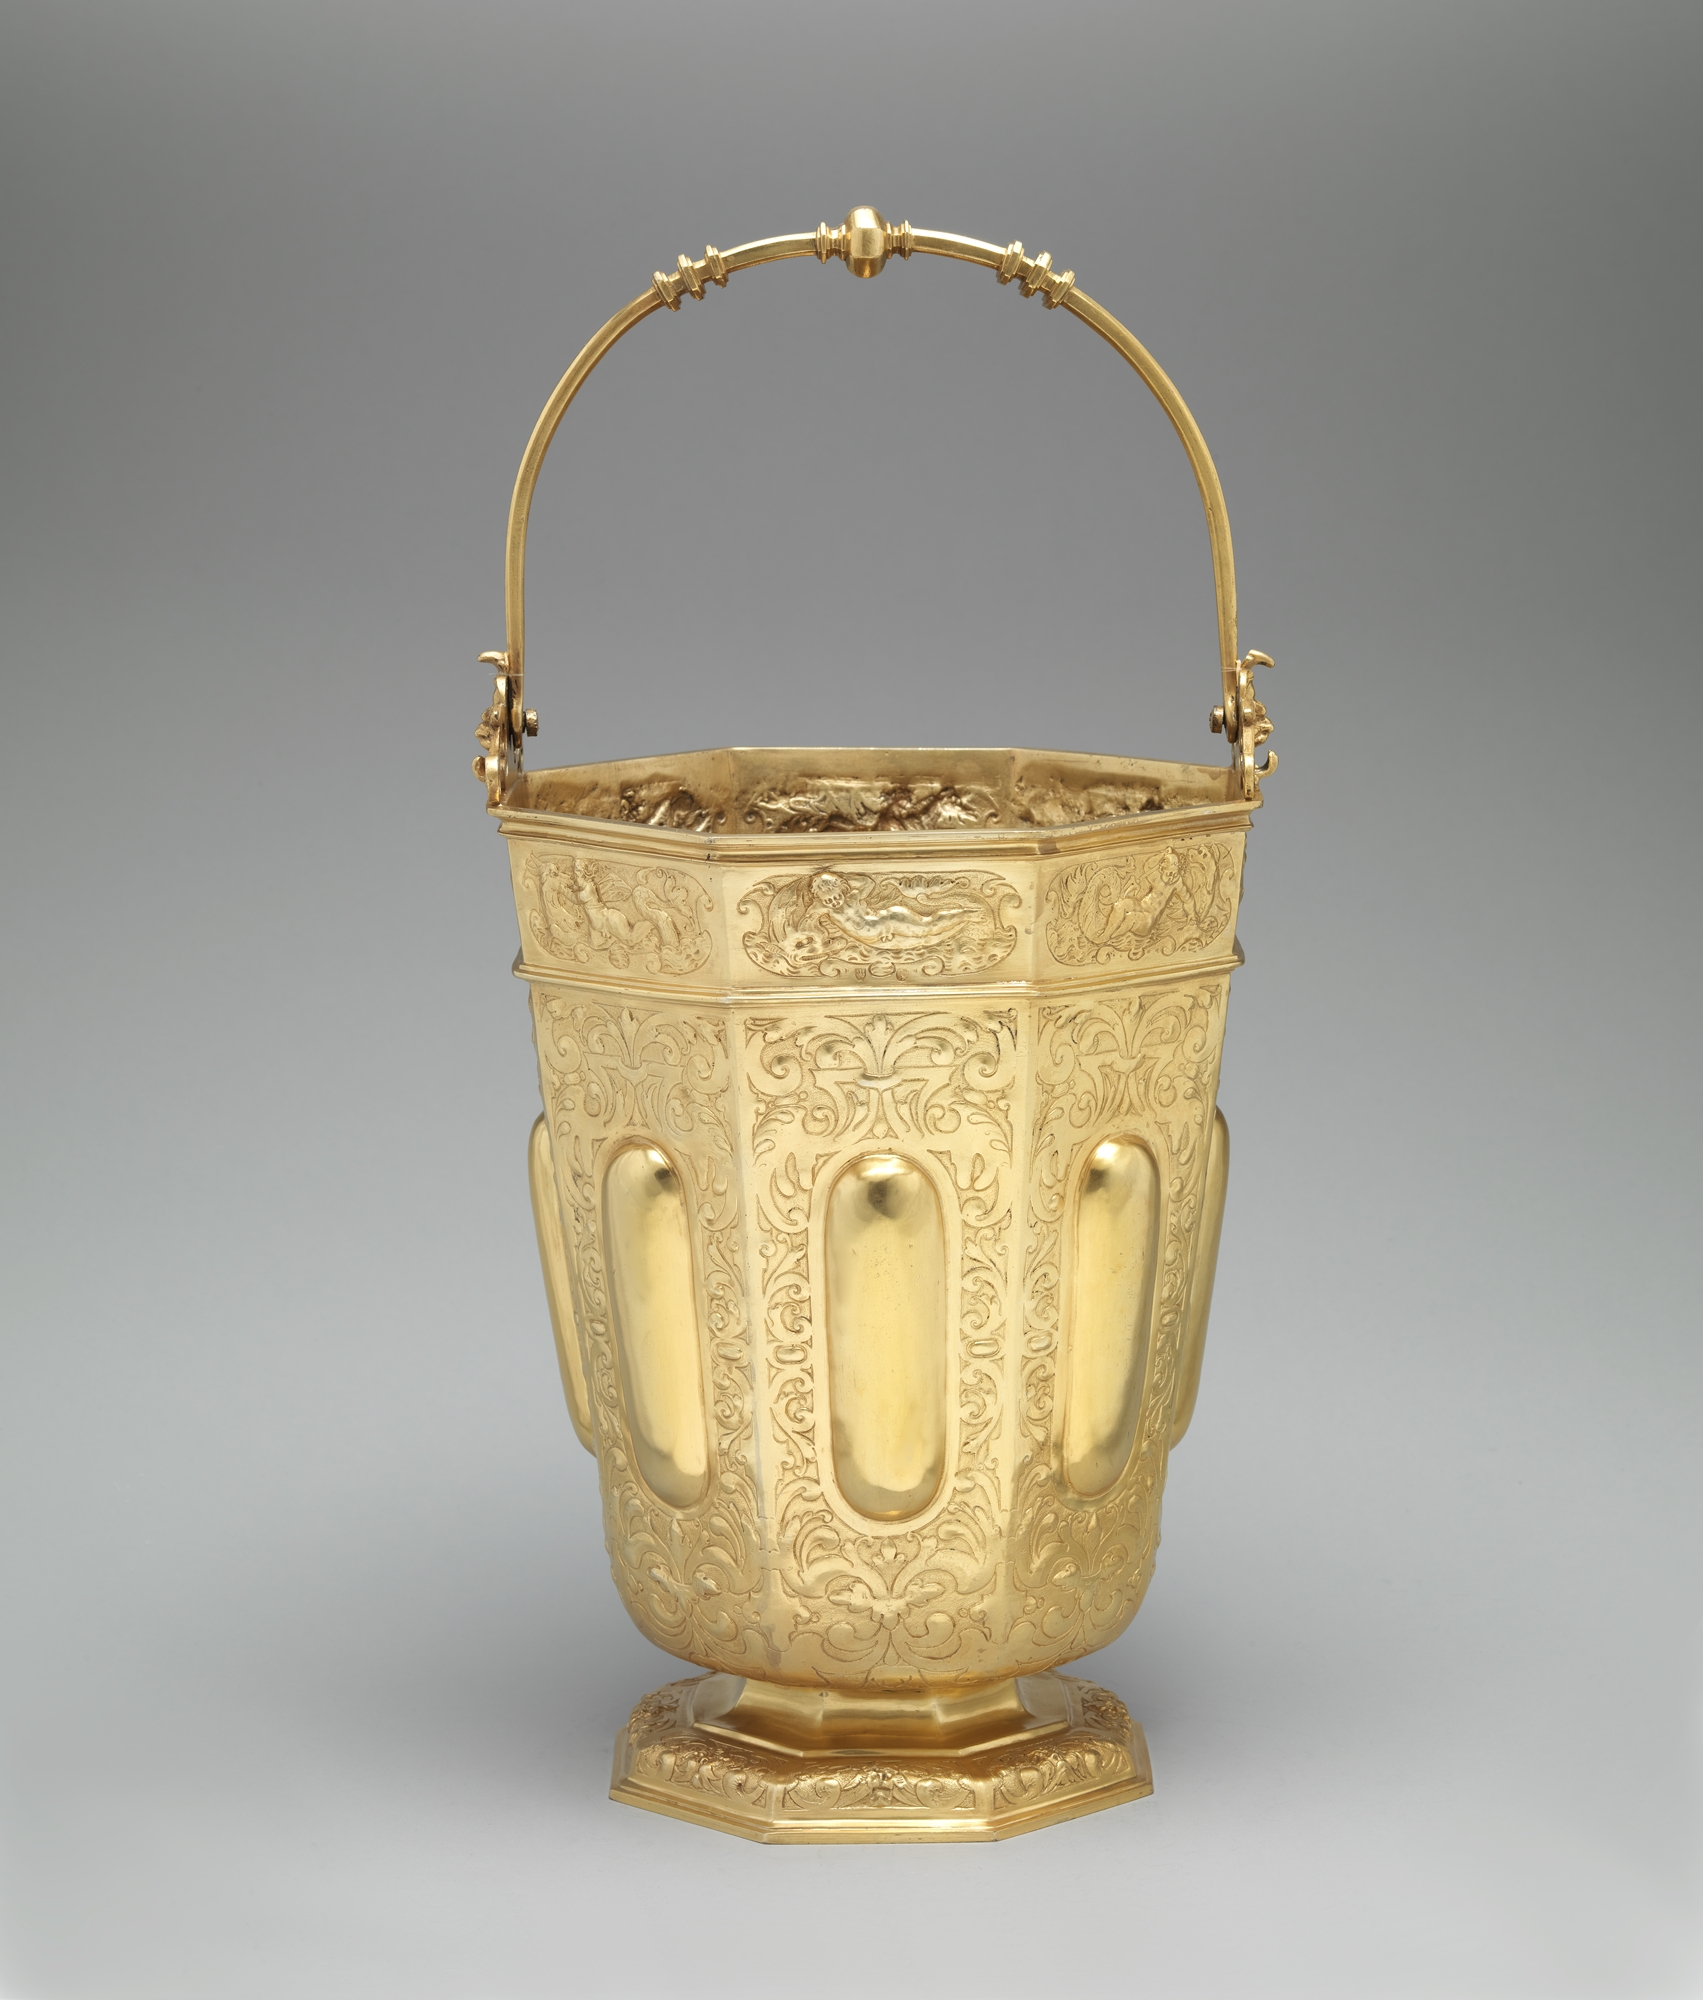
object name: pail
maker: elkington & co.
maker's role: manufacturer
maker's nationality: british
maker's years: 1829-1963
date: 1801-1900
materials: copper, gilt